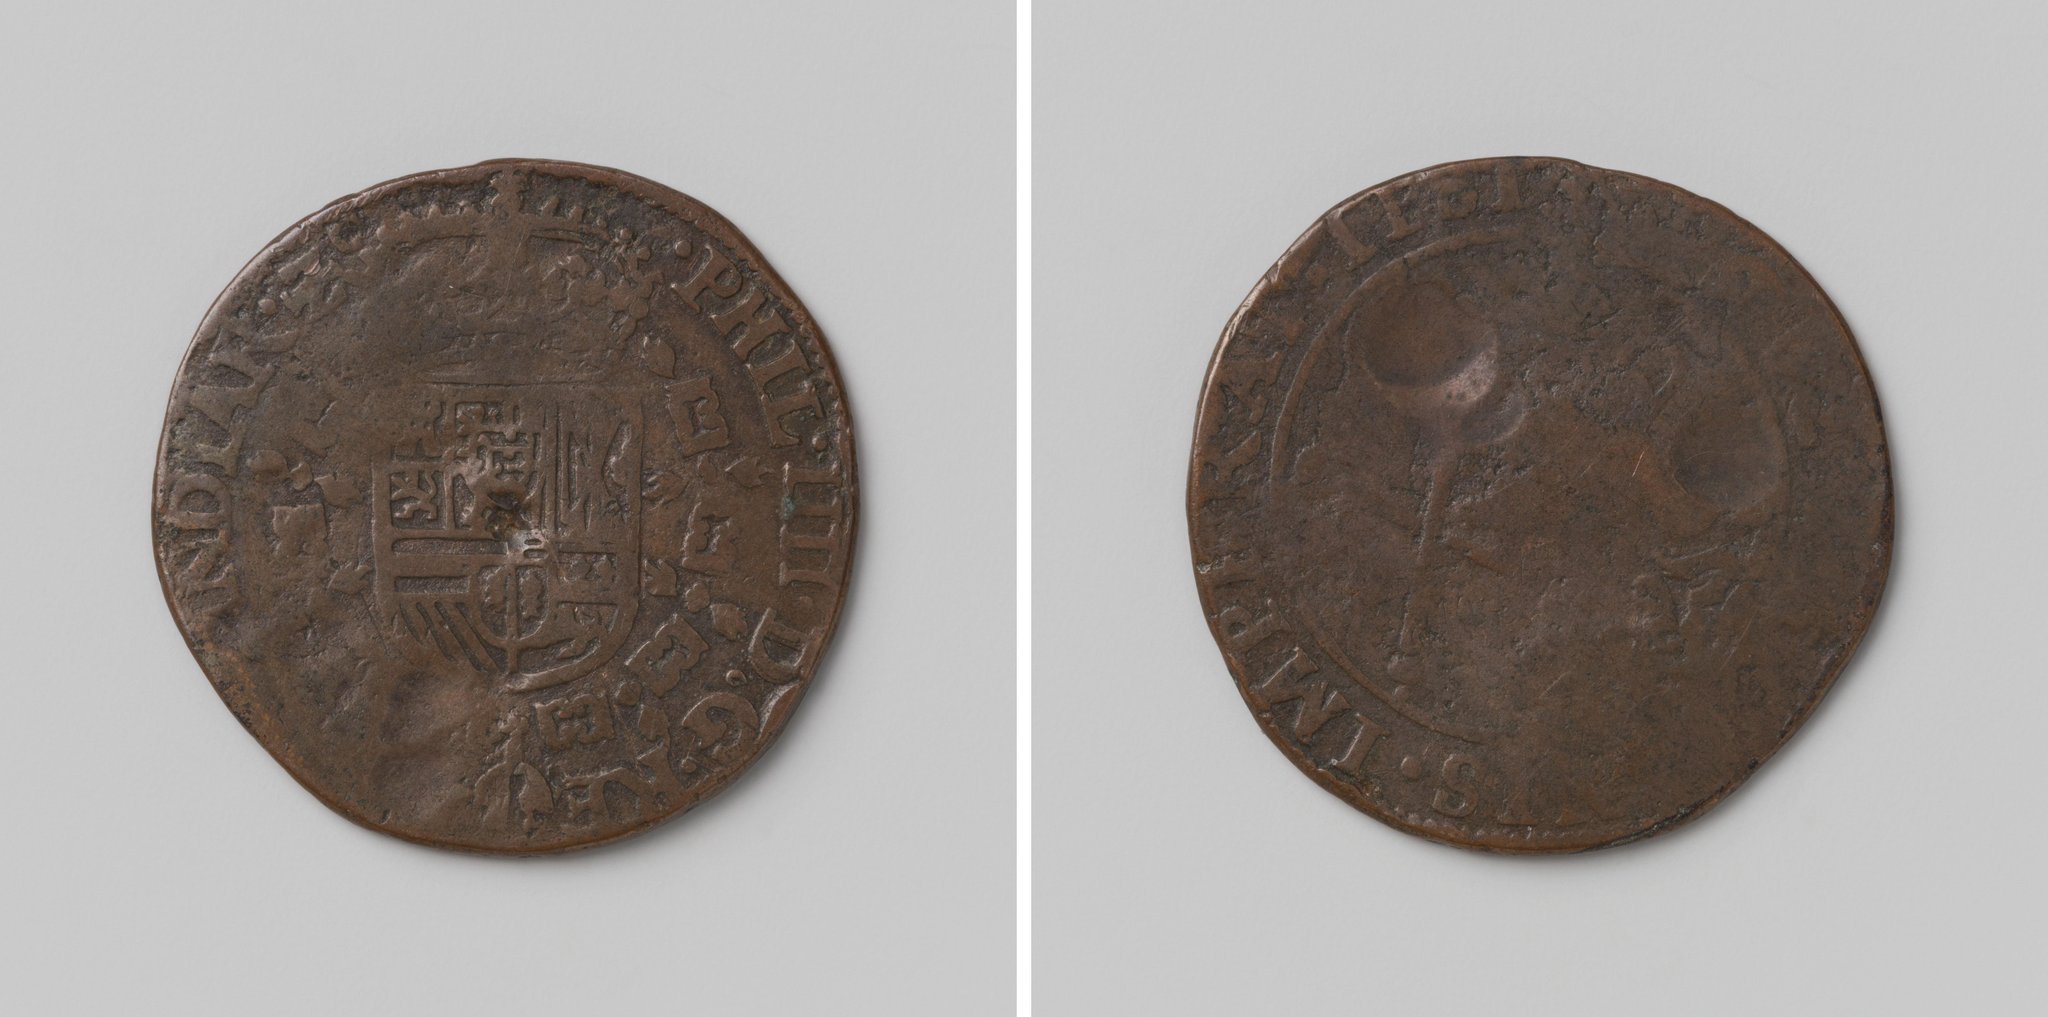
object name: jeton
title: Filips IV, koning van Spanje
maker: Anonymous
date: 1623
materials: copper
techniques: striking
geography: antwerp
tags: filips iv (koning van spanje)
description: Koperen penning. Voorzijde: gekroond wapenschild, omhangen met de orde van het Gulden Vlies binnen omschrift. Keerzijde: hand uit wolken houdt peillood boven twee gekruiste scepters binnen omschrift